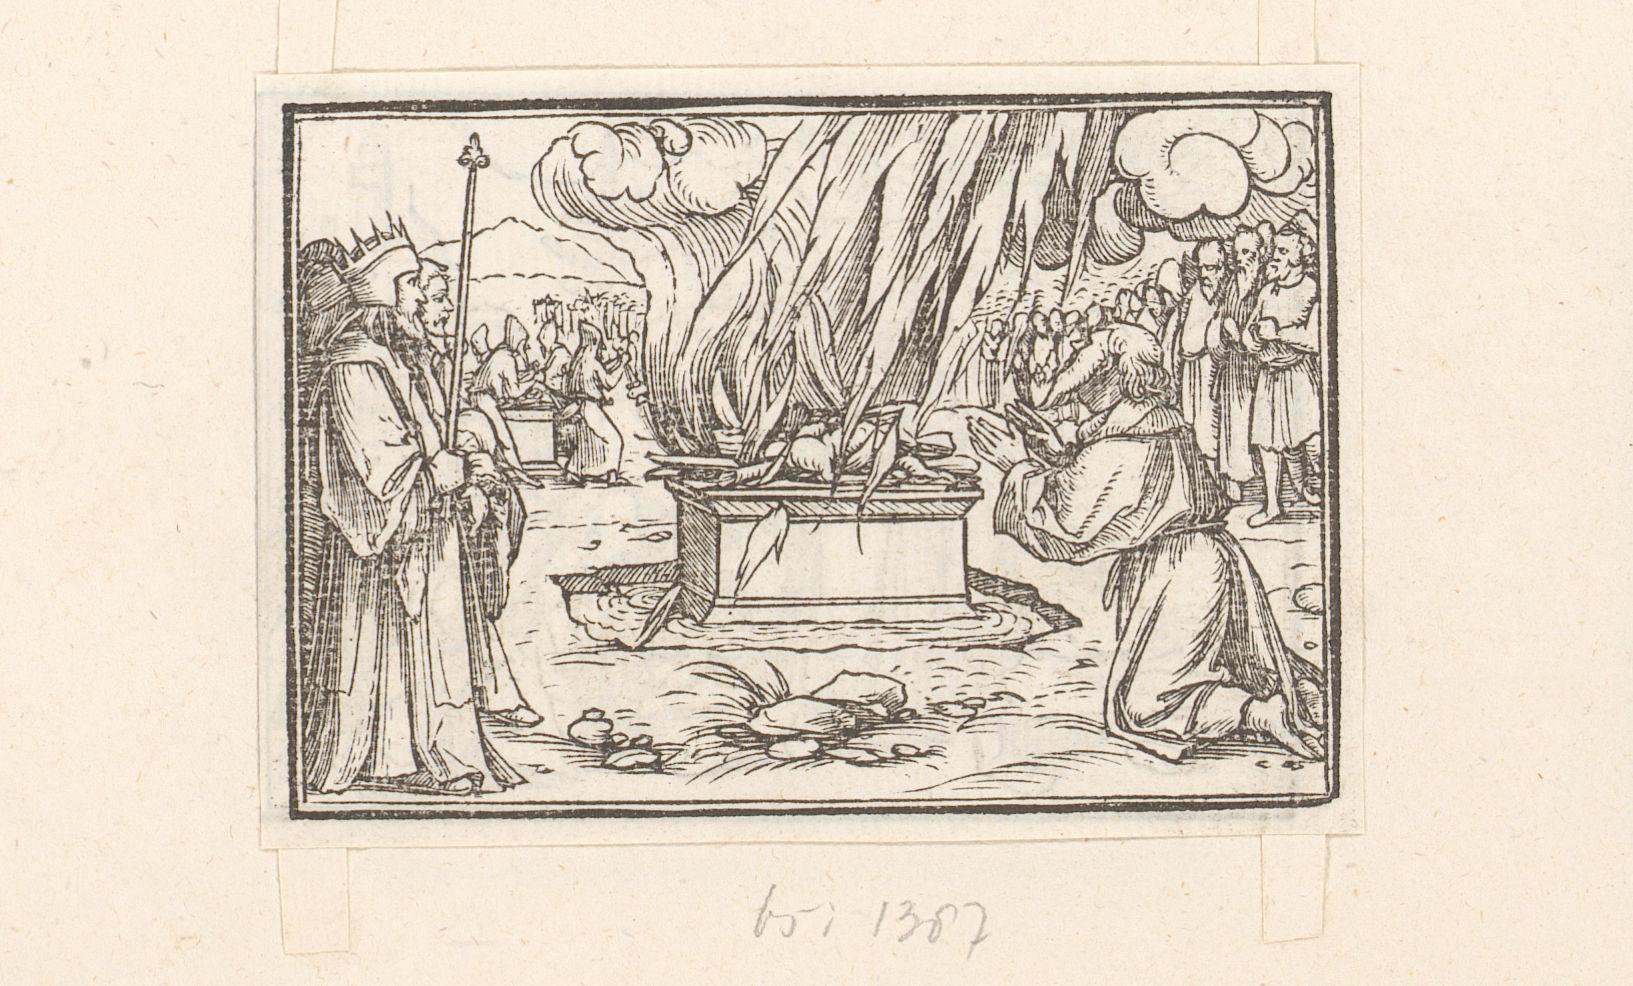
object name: print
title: Offer van Elia door vuur verteerd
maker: veit rudolf specklin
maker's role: print maker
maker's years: -1550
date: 1538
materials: paper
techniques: woodcut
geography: switzerland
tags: as elijah prays, god sends fire which burns up not only his sacrifice but also the altar itself; the people fall prostrate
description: Boekillustratie voor het eerst gebruikt in: Biblia Utriusque Testamenti iuxta Vulgatam Translationem, Lyon, M. en G. Trechsel (voor Hugo à Porta) 1538. Later in verschillende uitgaven opnieuw gebruikt. Deze prent vermoedelijk gebruikt in één van de uitgaven uitgegeven en/of gedrukt door Jean Frellon, Lyon.